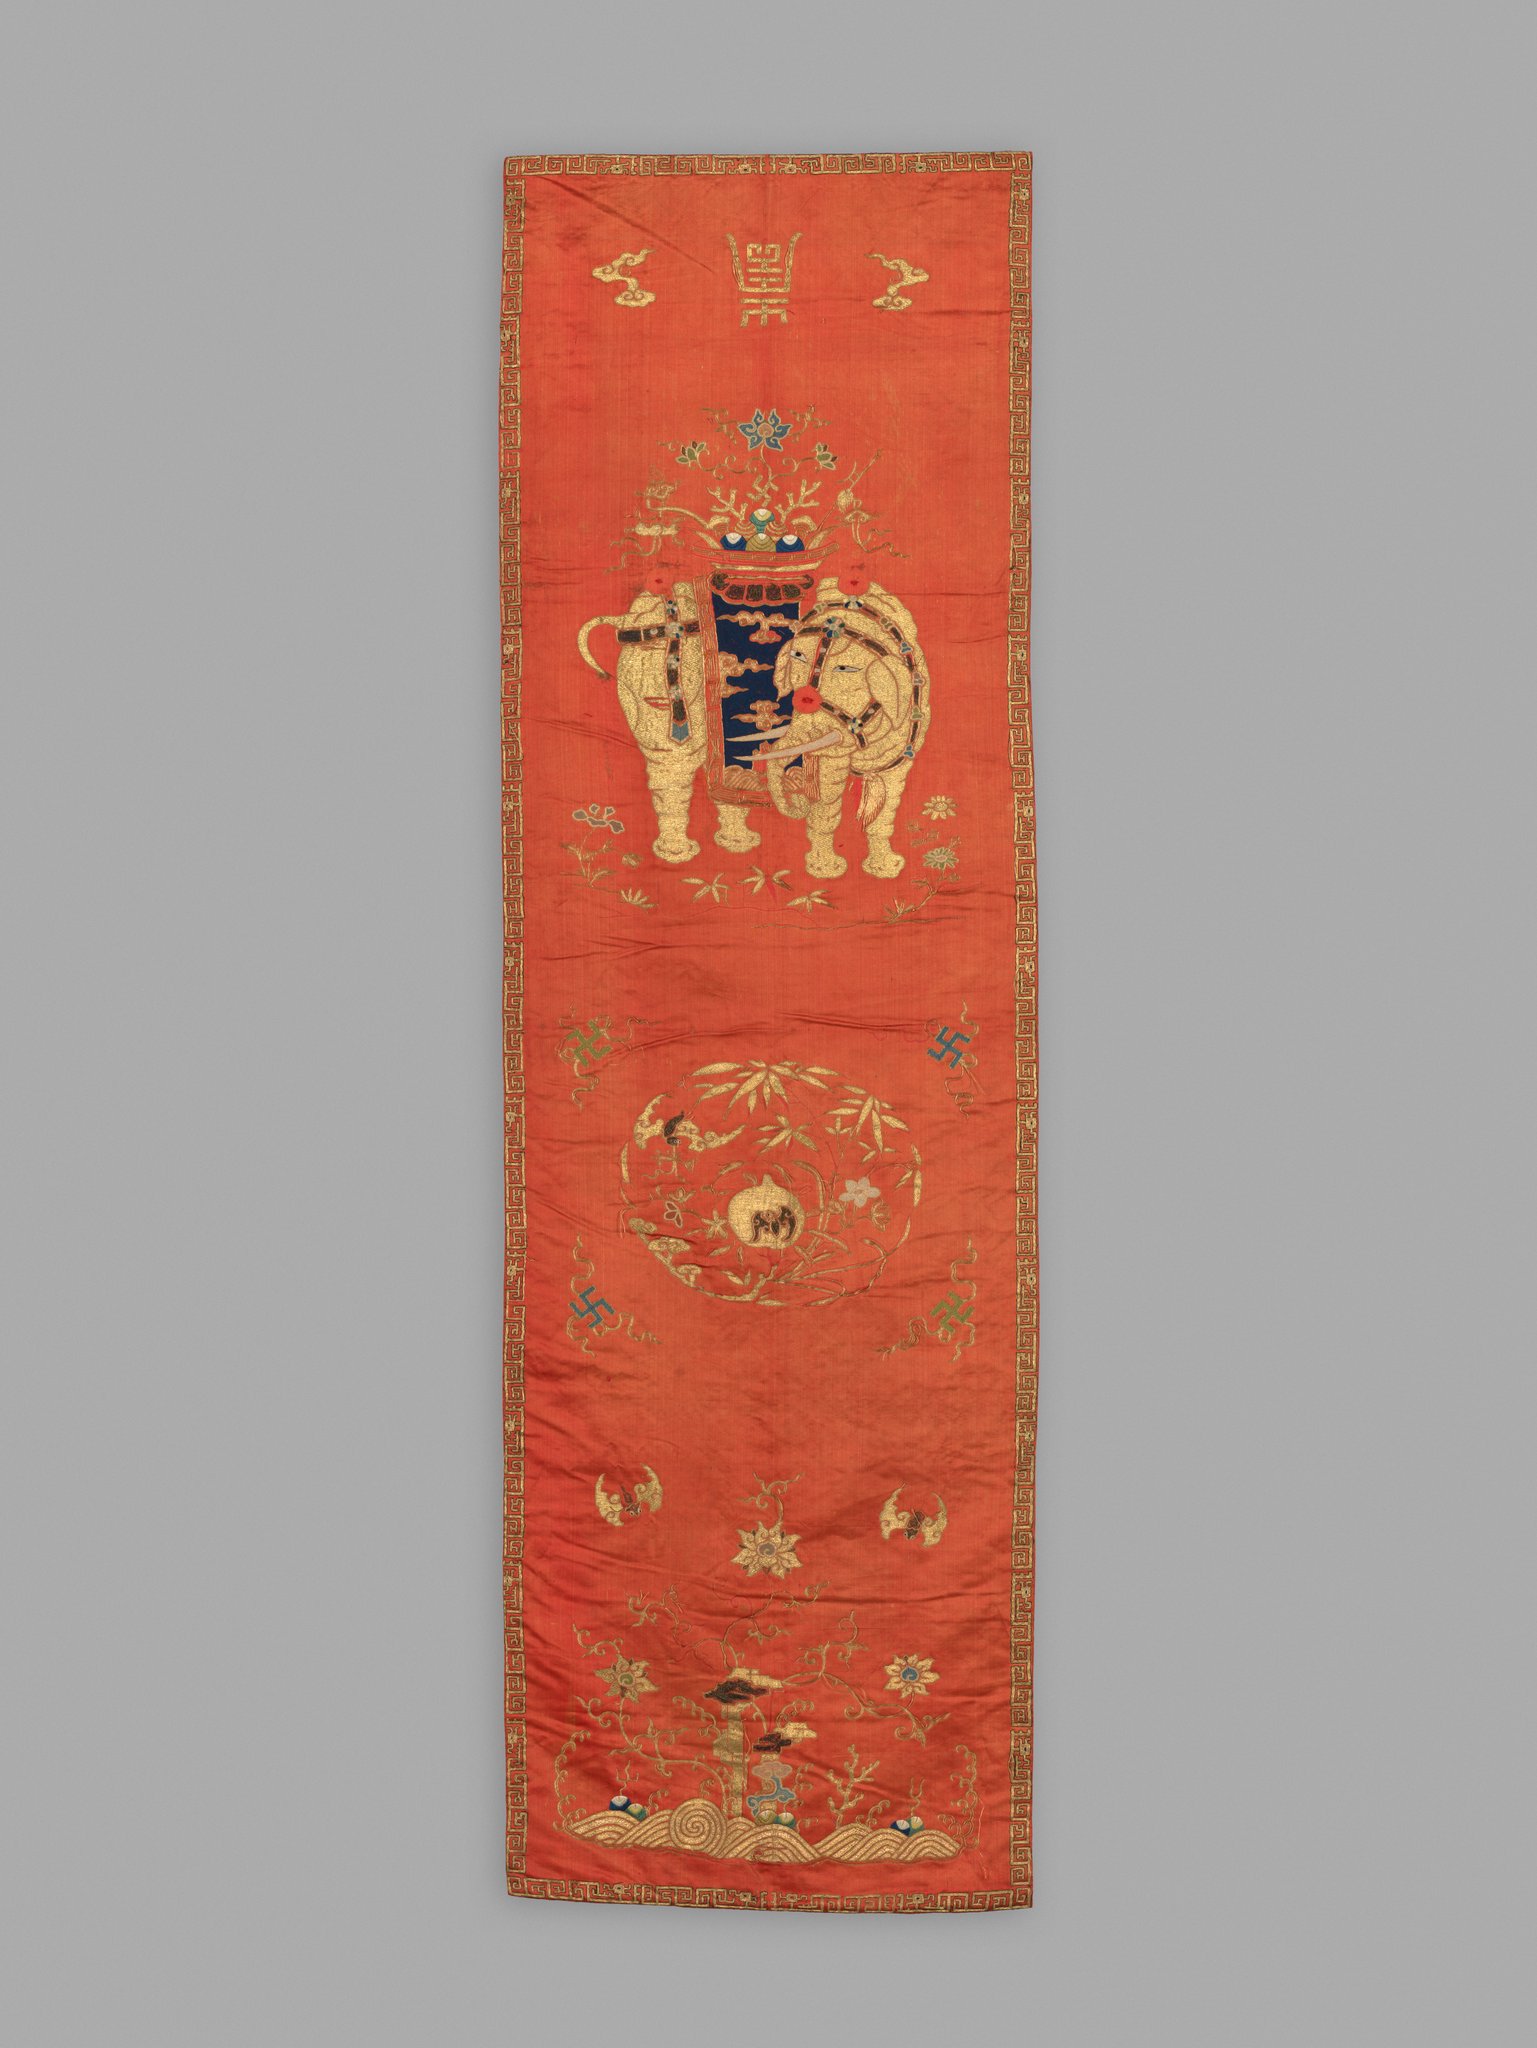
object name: chair strip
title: Table Vallance with Elephant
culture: chinese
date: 1736-1795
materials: metal thread, silk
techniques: embroidery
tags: elephants